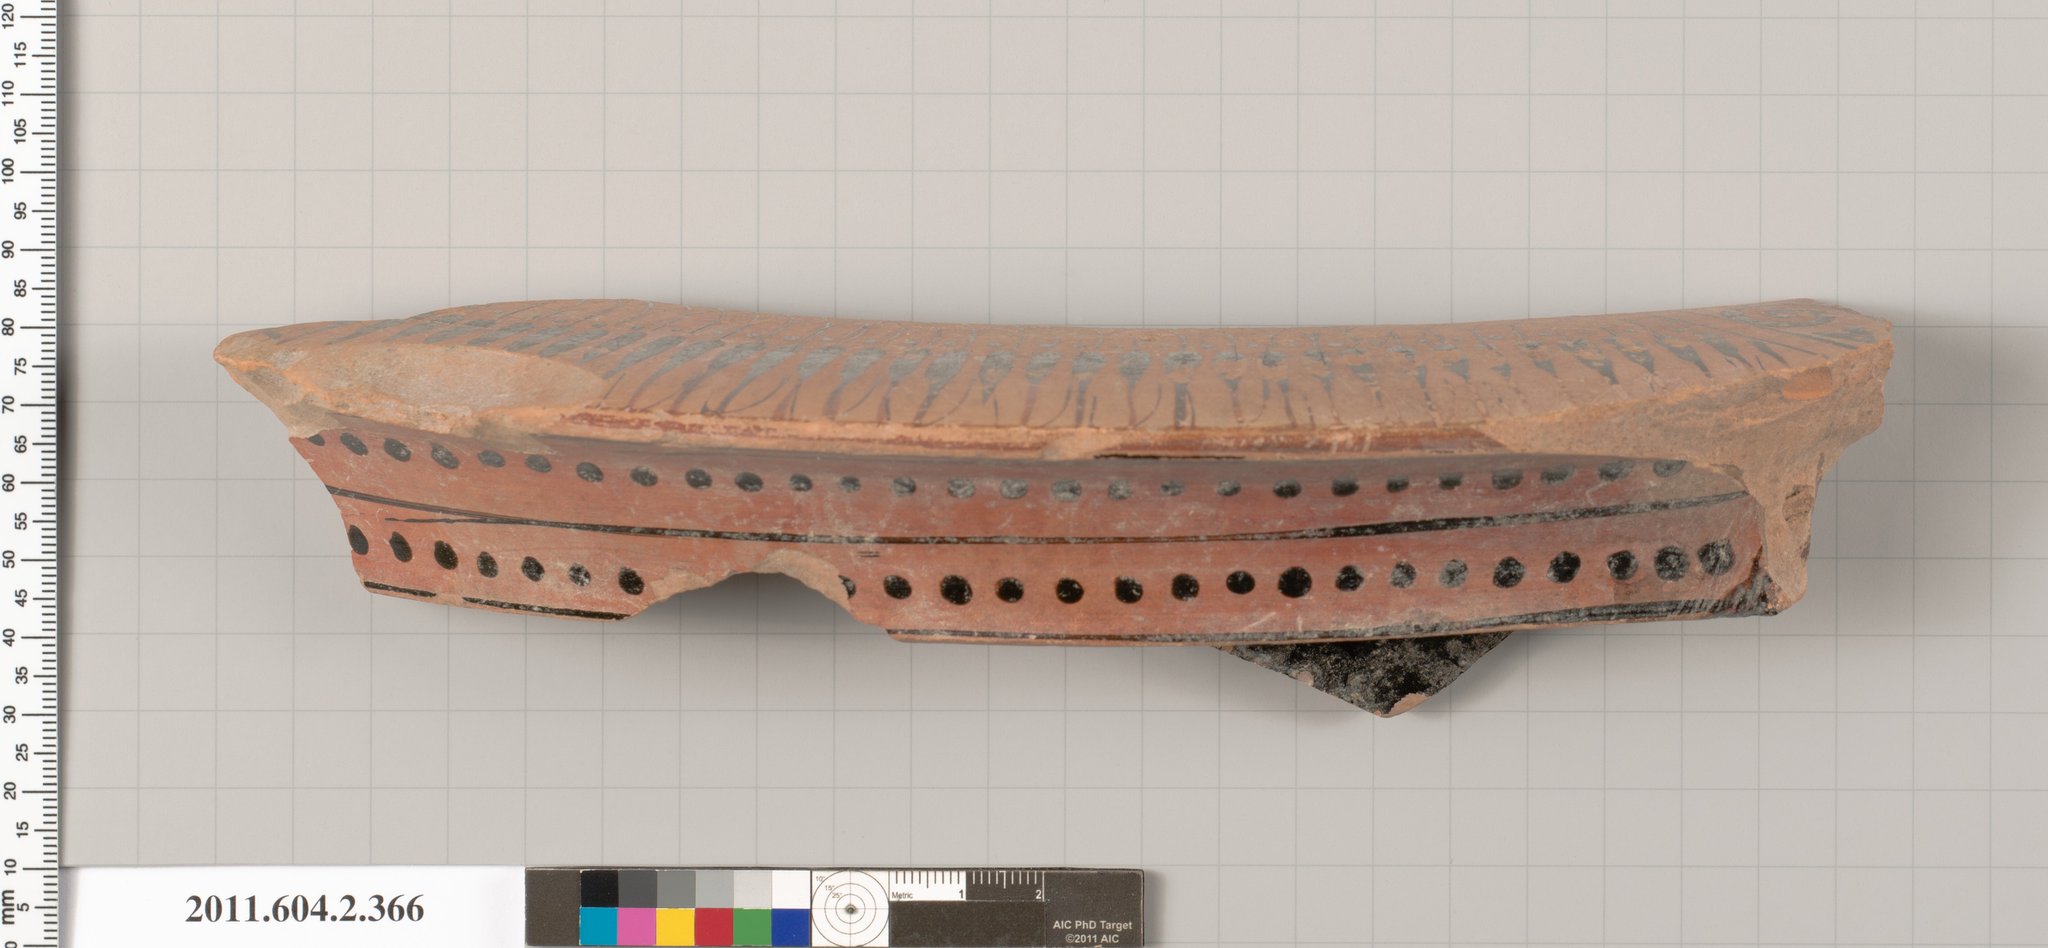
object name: column krater fragment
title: Terracotta fragment of a column-krater (bowl for mixing wine and water)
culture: greek, attic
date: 450-430 BCE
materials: terracotta